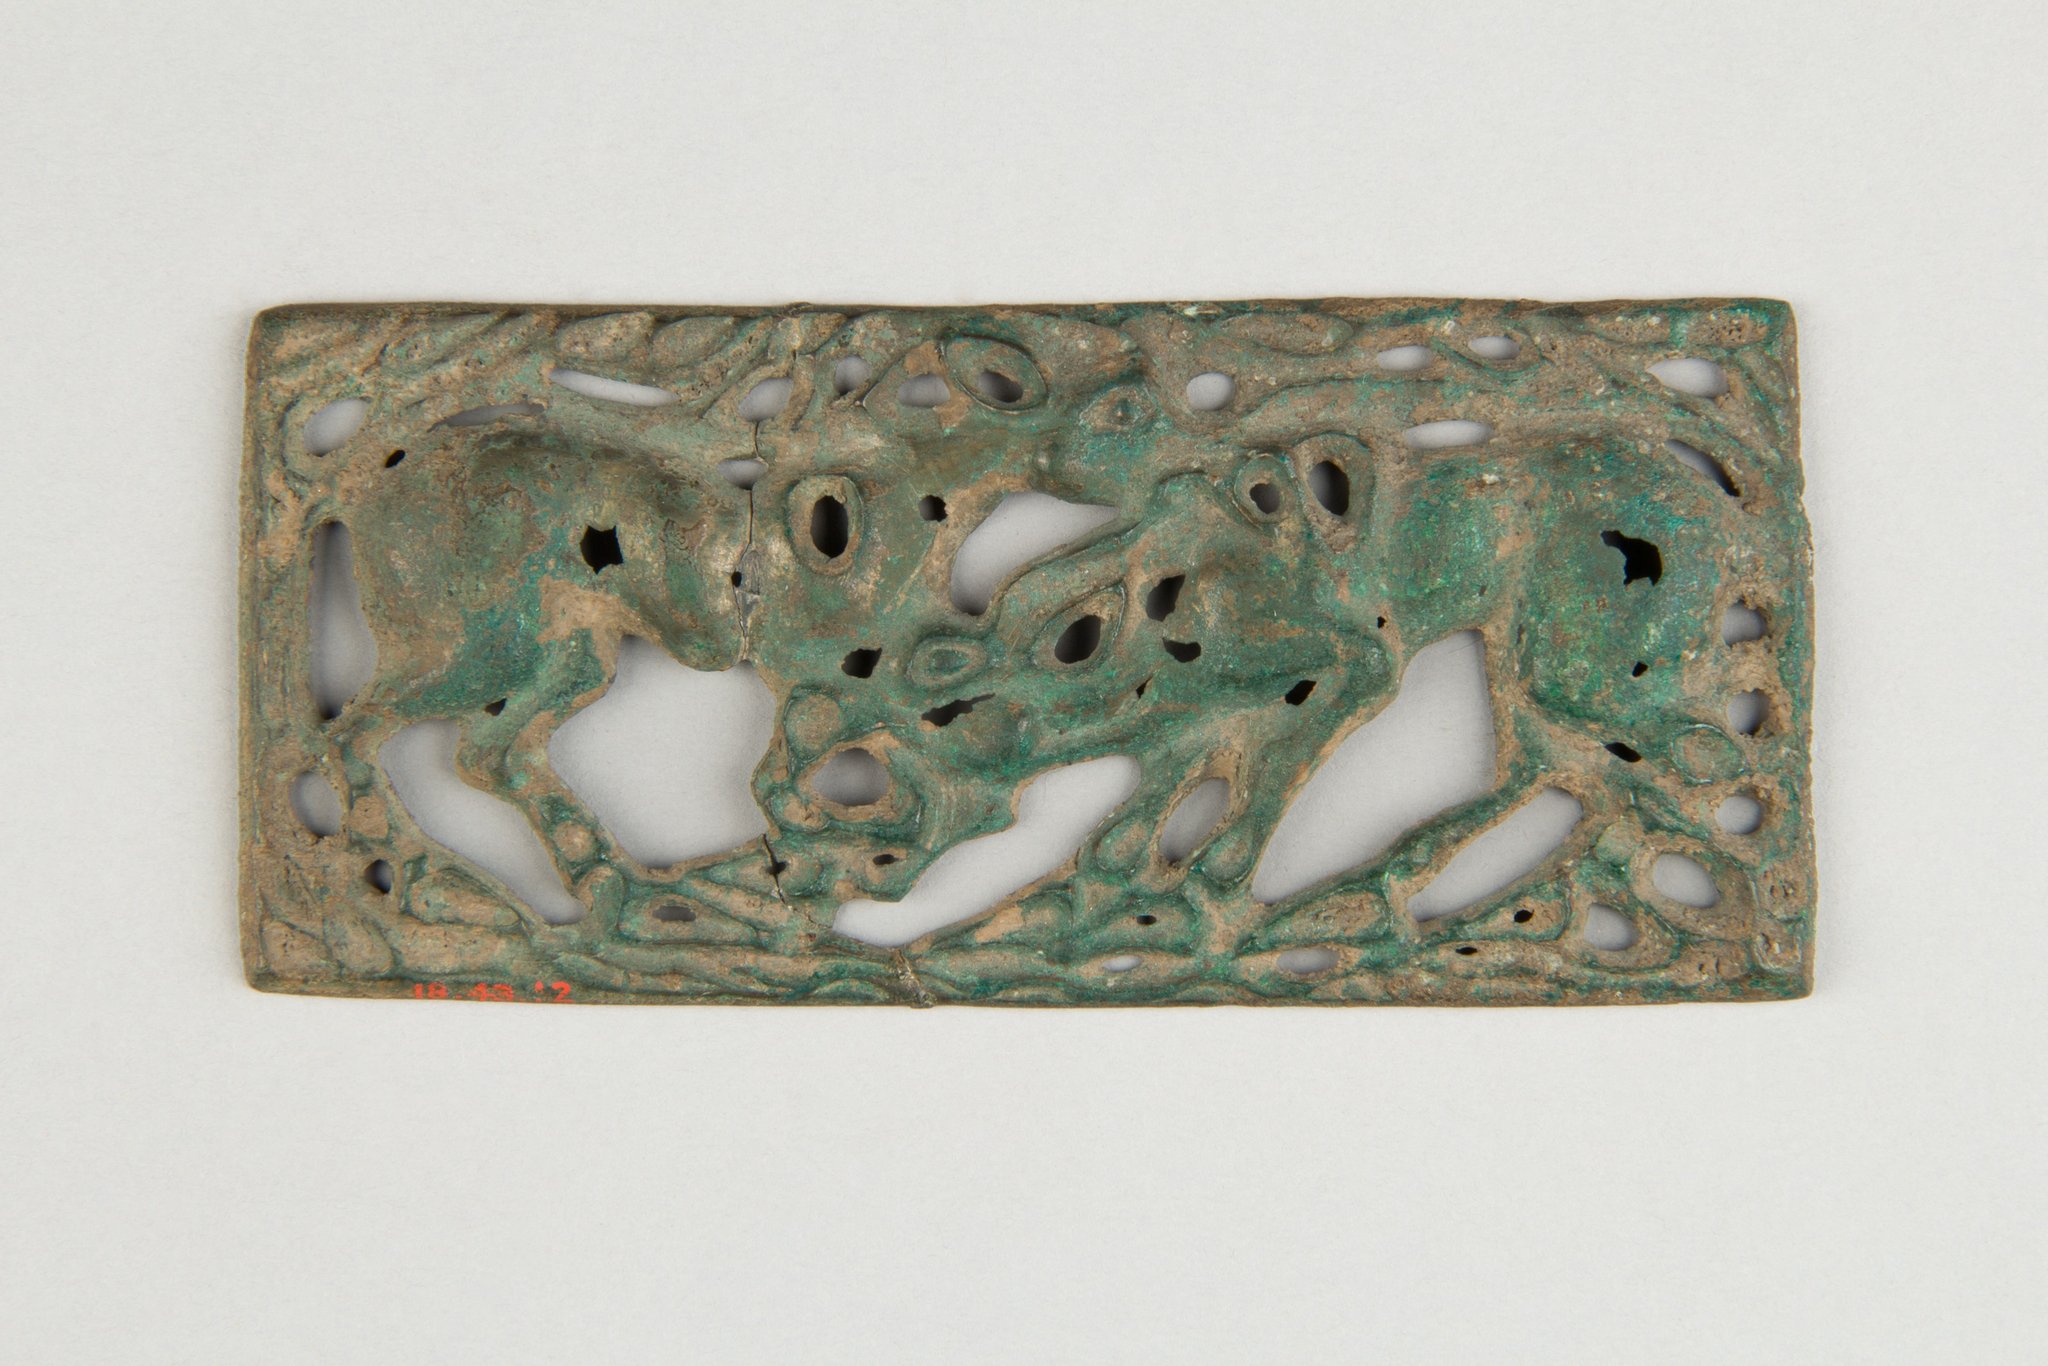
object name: belt plaque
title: Belt Plaque with Fighting Horses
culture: northwest chinese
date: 200-1 BCE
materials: bronze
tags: horses